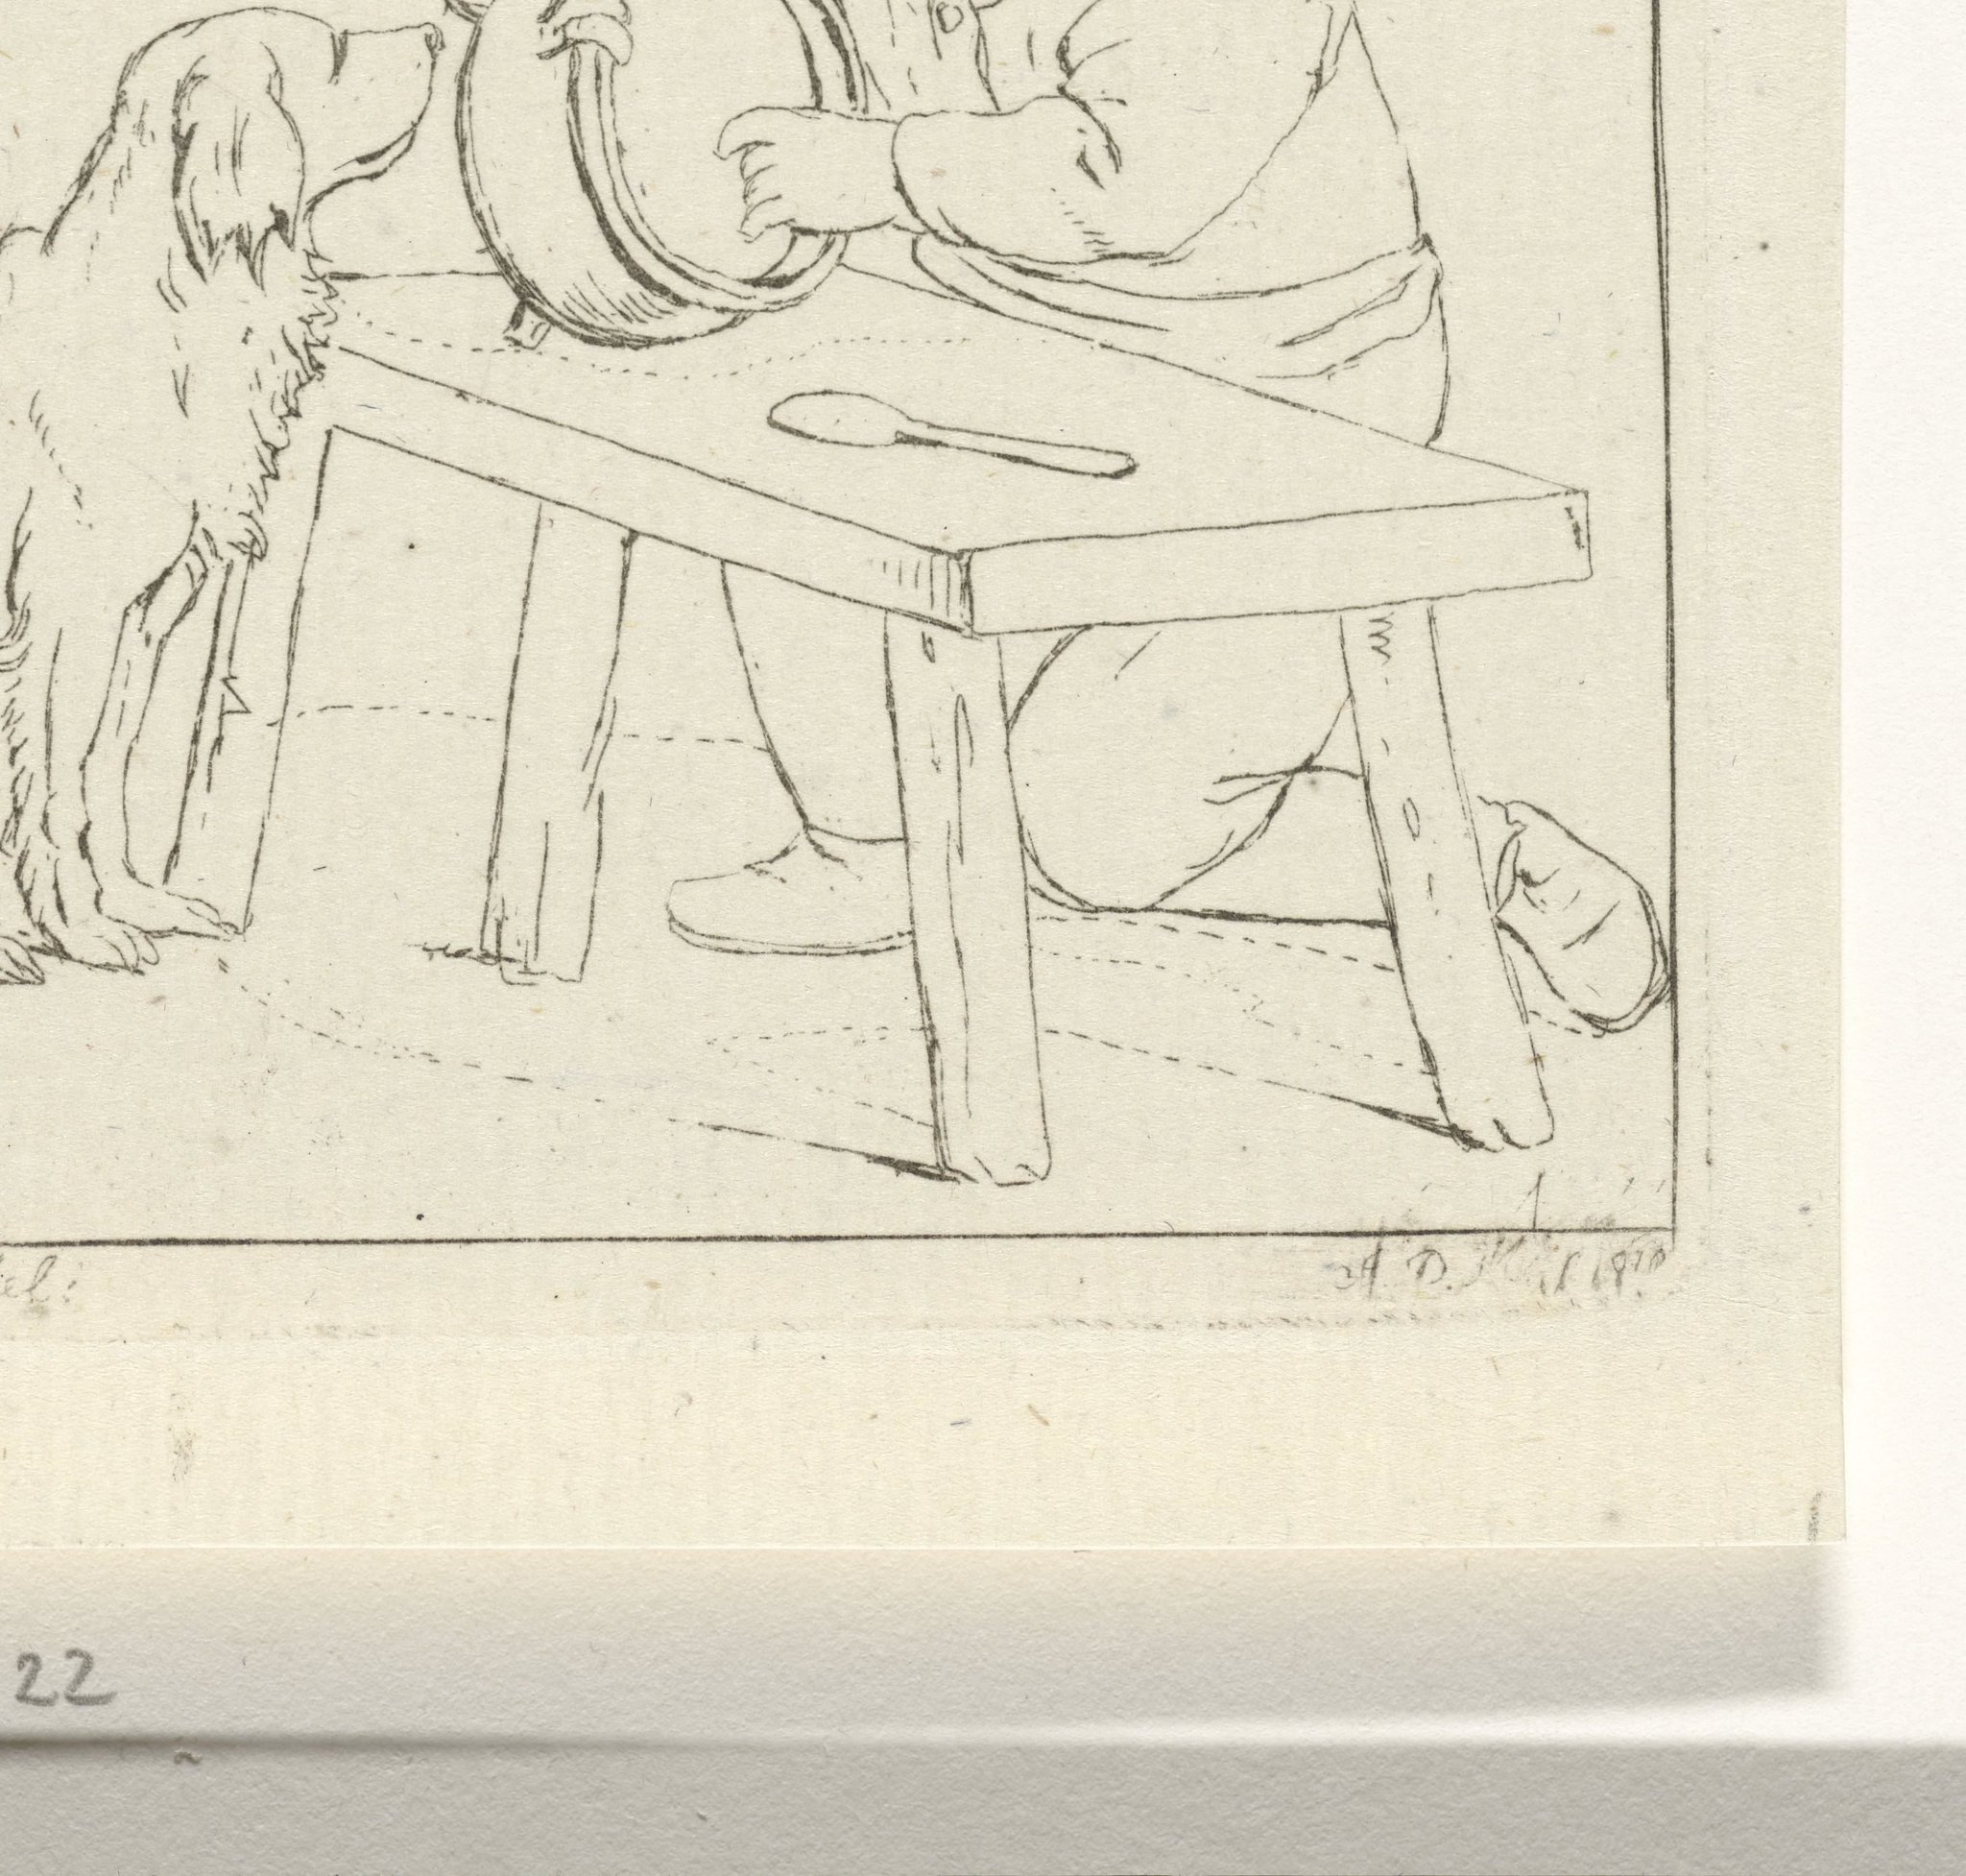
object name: print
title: Jongen met hond en een lege pot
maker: johannes huibert prins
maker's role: draughtsman, painter, print maker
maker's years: 1757-1806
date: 1810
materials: paper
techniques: etching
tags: kitchen-utensils, spoon, dog, container of metal: bucket, can, canister, drum, tin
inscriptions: collector's mark: Lugt 2228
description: Een jongen bij een tafel, waarop een lepel ligt. Hij likt een pot uit. Voor hem zit een hond.